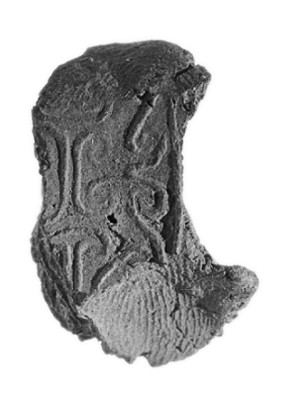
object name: sealing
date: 1981-1640 BCE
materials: clay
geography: egypt